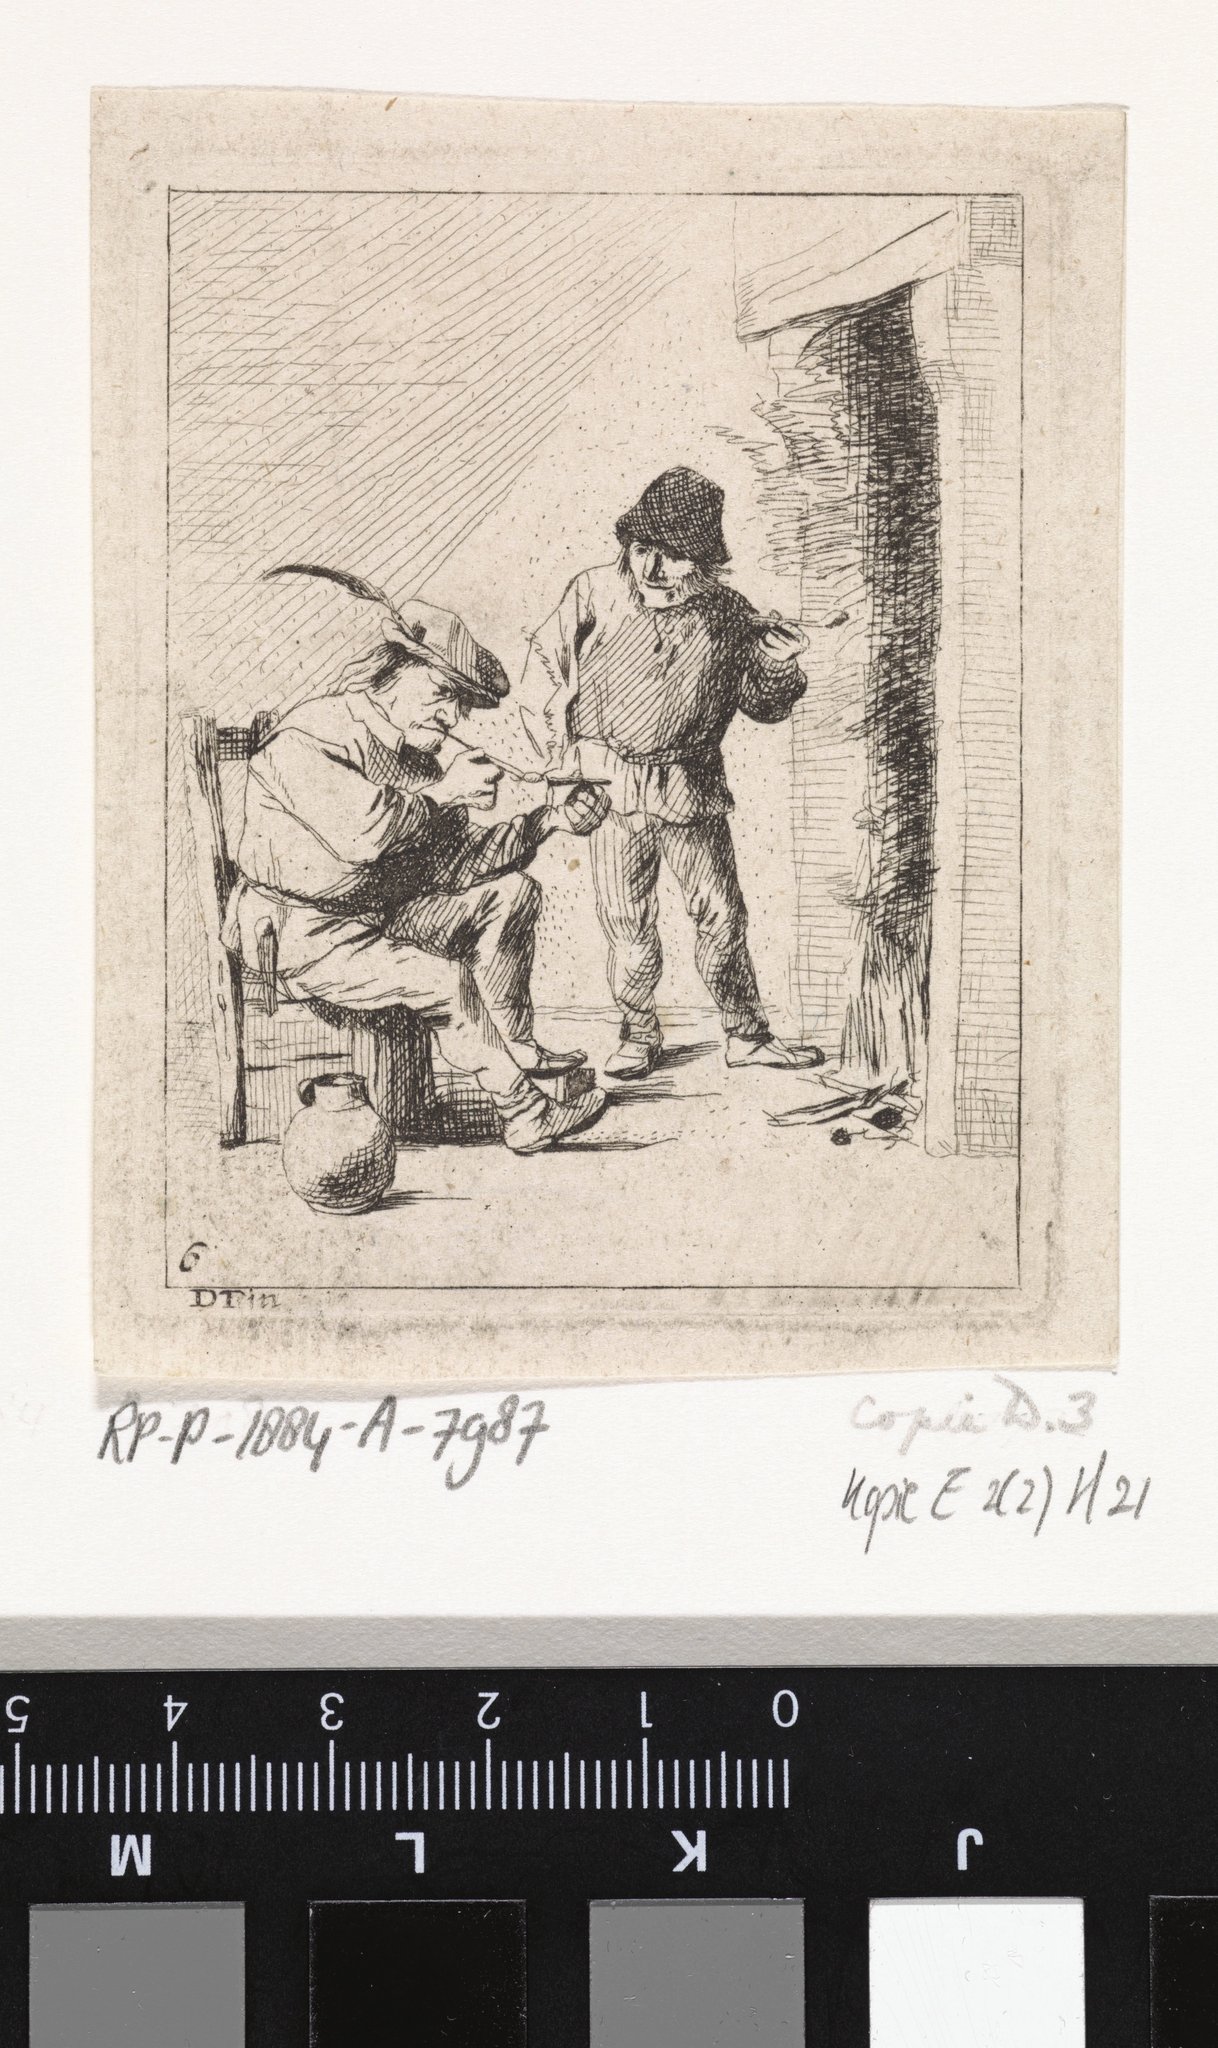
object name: print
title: Boeren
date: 1626-1740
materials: paper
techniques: etching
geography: low countries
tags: pipe ~ tobacco, open hearth, fire-place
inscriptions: collector's mark: Lugt 2228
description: Een staande en een zittende boer roken allebei pijp bij de haard. Links een kruik.